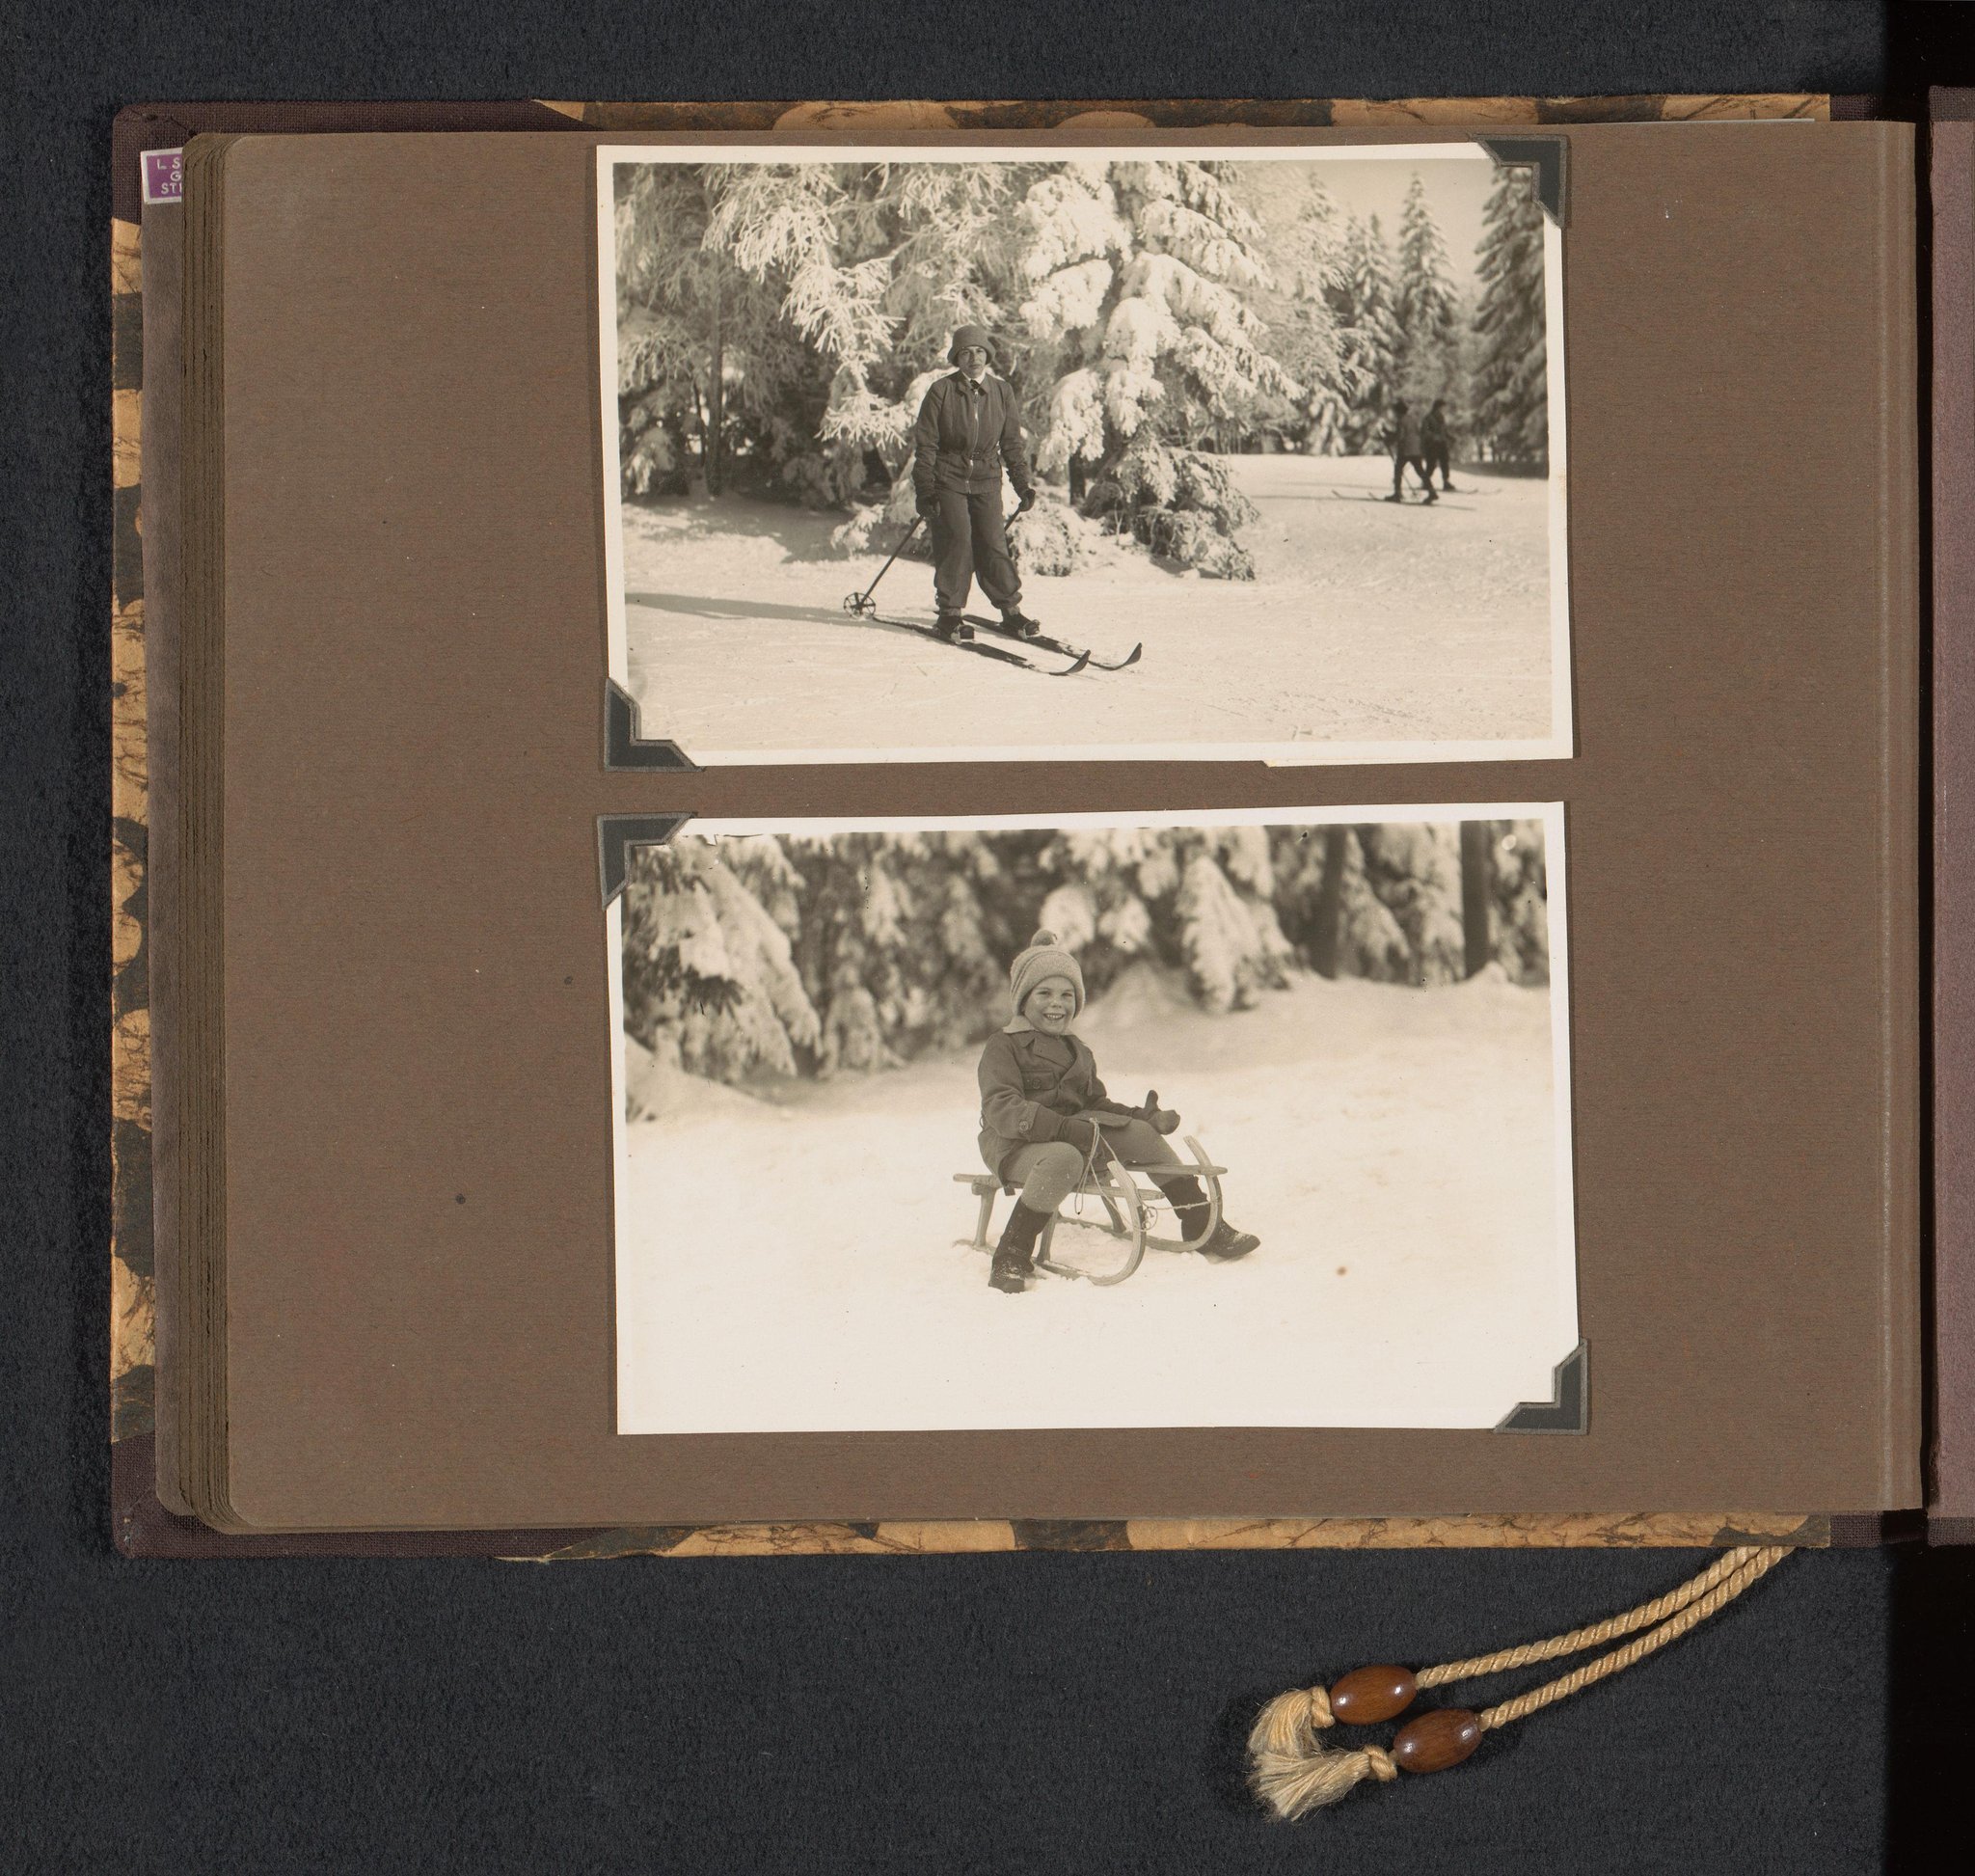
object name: photograph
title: Onbekende personen, mogelijk tijdens rondreis van Eugen Wachenheimer en Else Wachenheimer-Moos door Bulgarije, 1926-1927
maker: else wachenheimer-moos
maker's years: 1895-1944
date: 1926-1927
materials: paper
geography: bulgaria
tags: bulgarije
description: Albumblad bevat twee foto's van onbekende personen. Afkomstig uit album half formaat, kartonomslag met koordbinding en lichte veelvormige vormen op voorzijde.